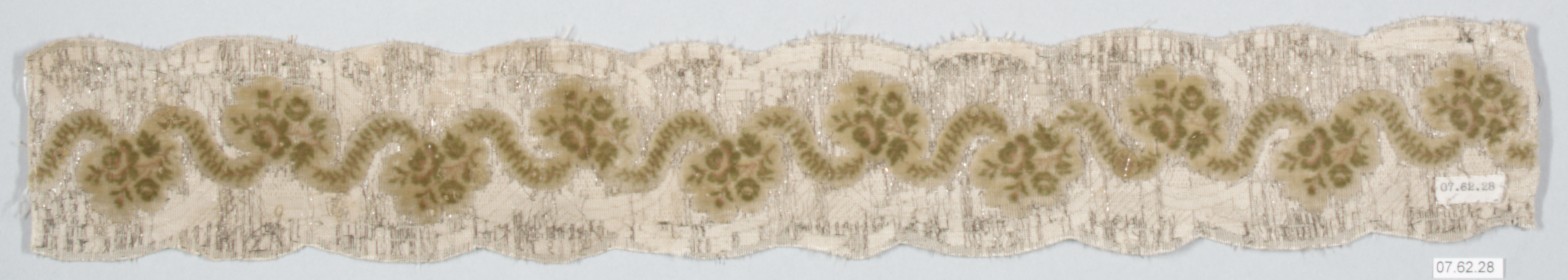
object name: ribbon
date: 1701-1800